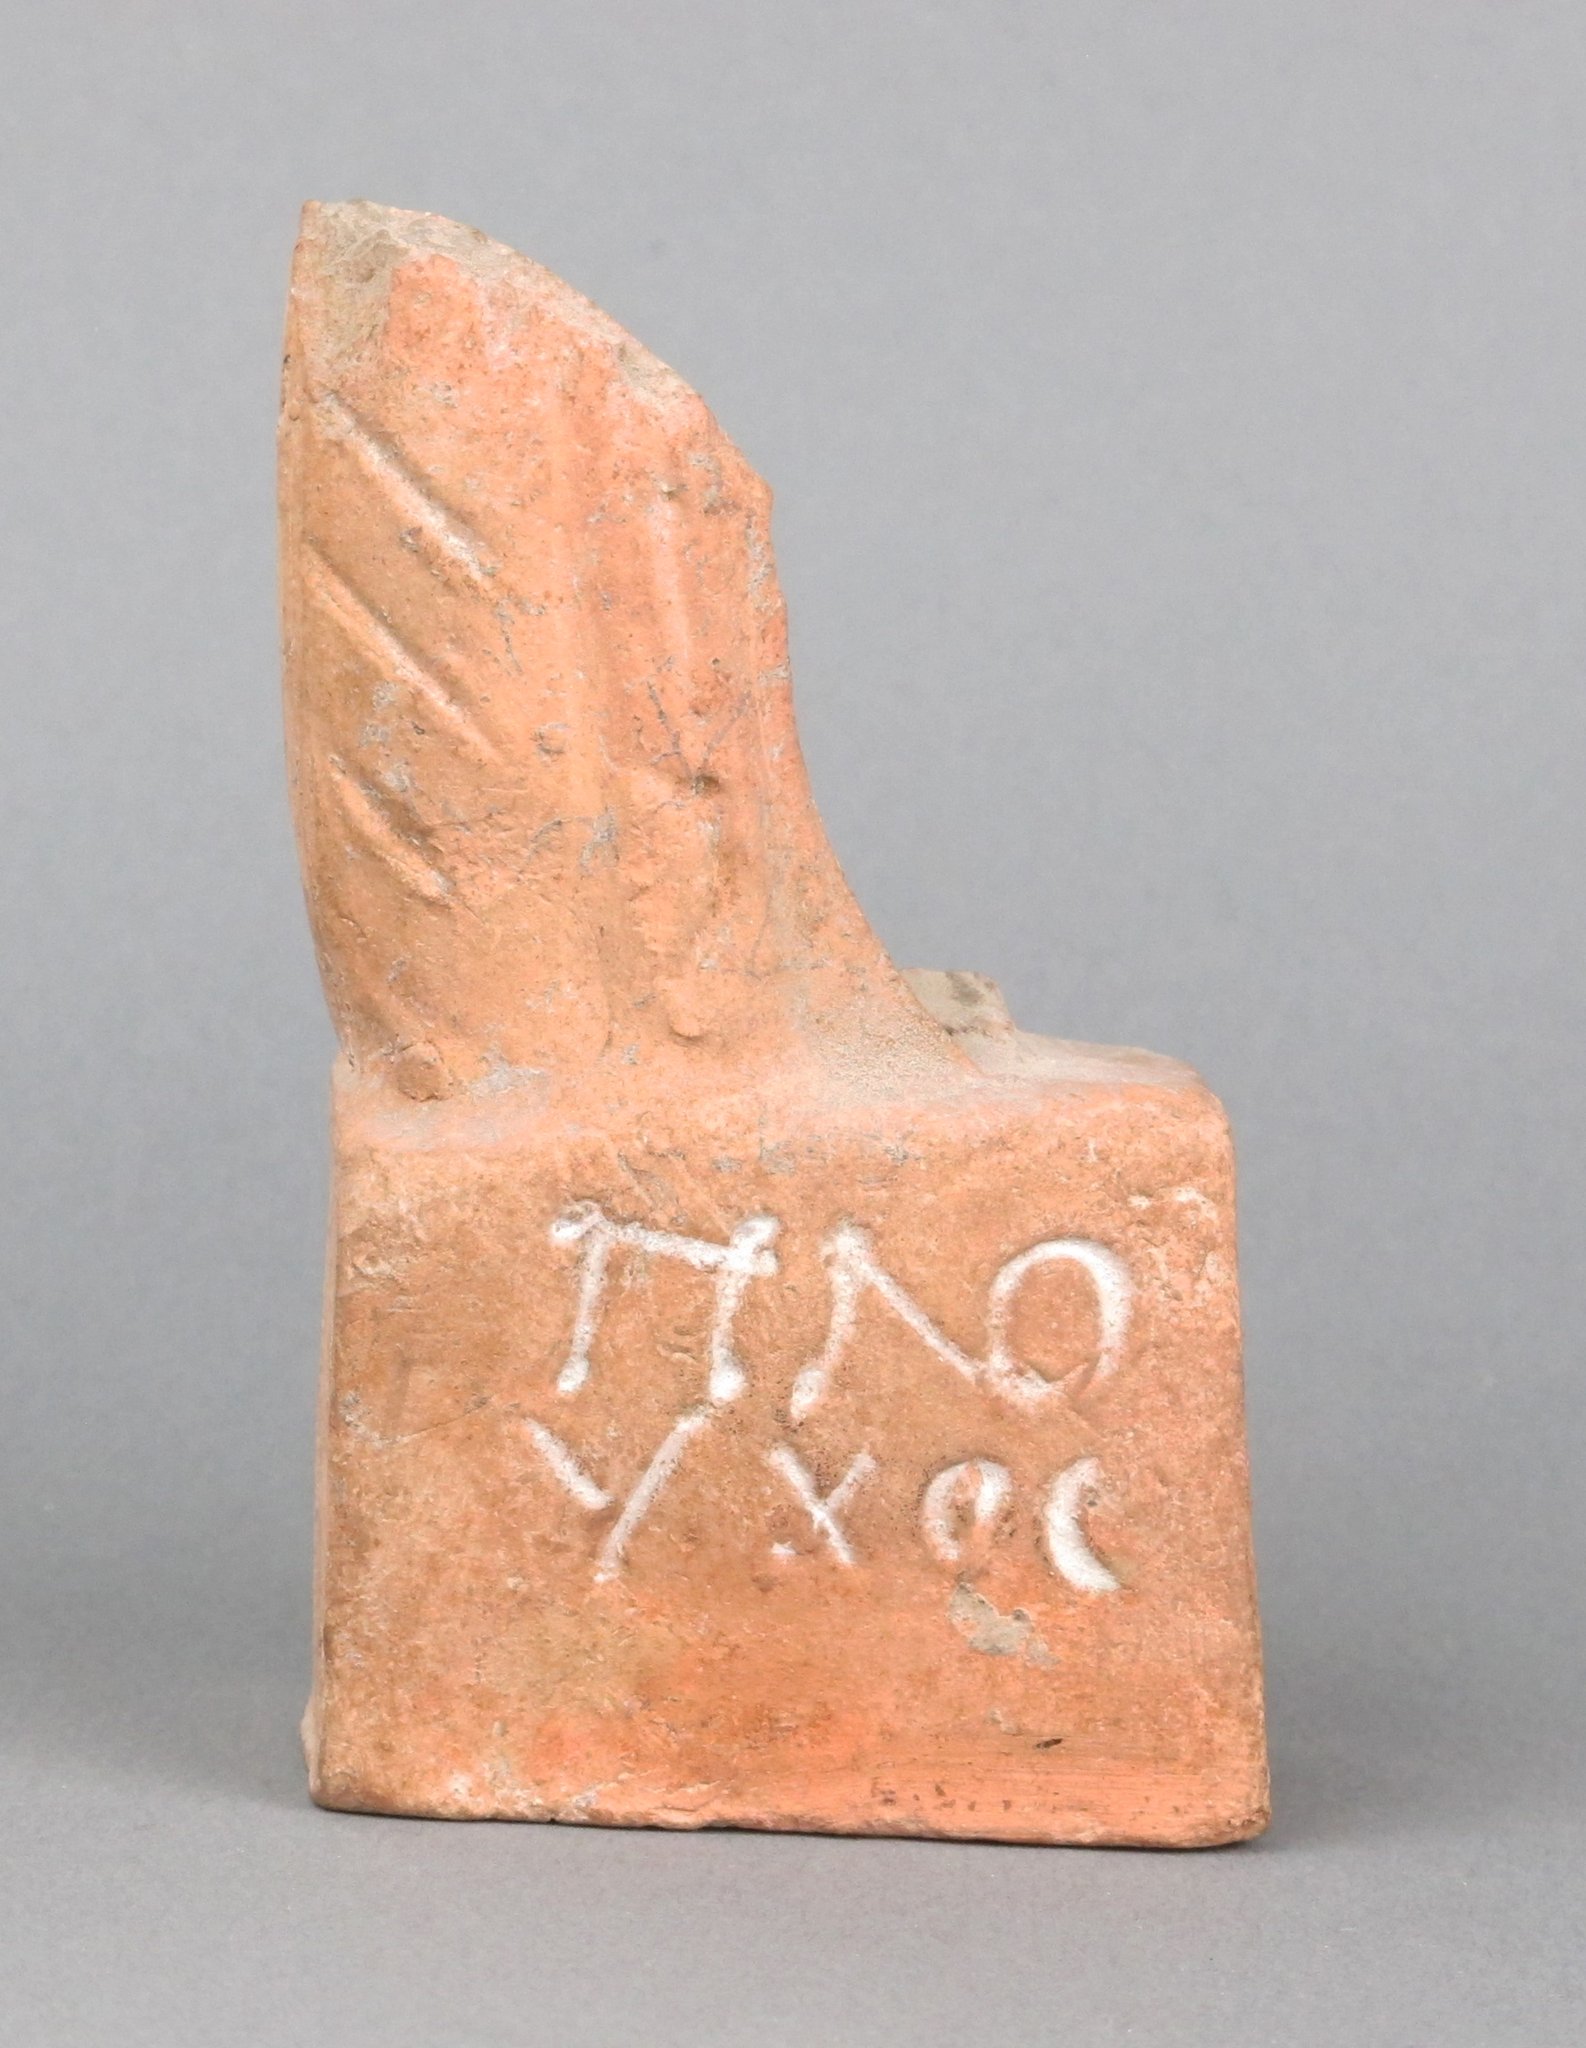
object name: statue base, inscribed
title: Terracotta figurine fragment with base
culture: cypriot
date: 3900 BCE-100 CE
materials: terracotta